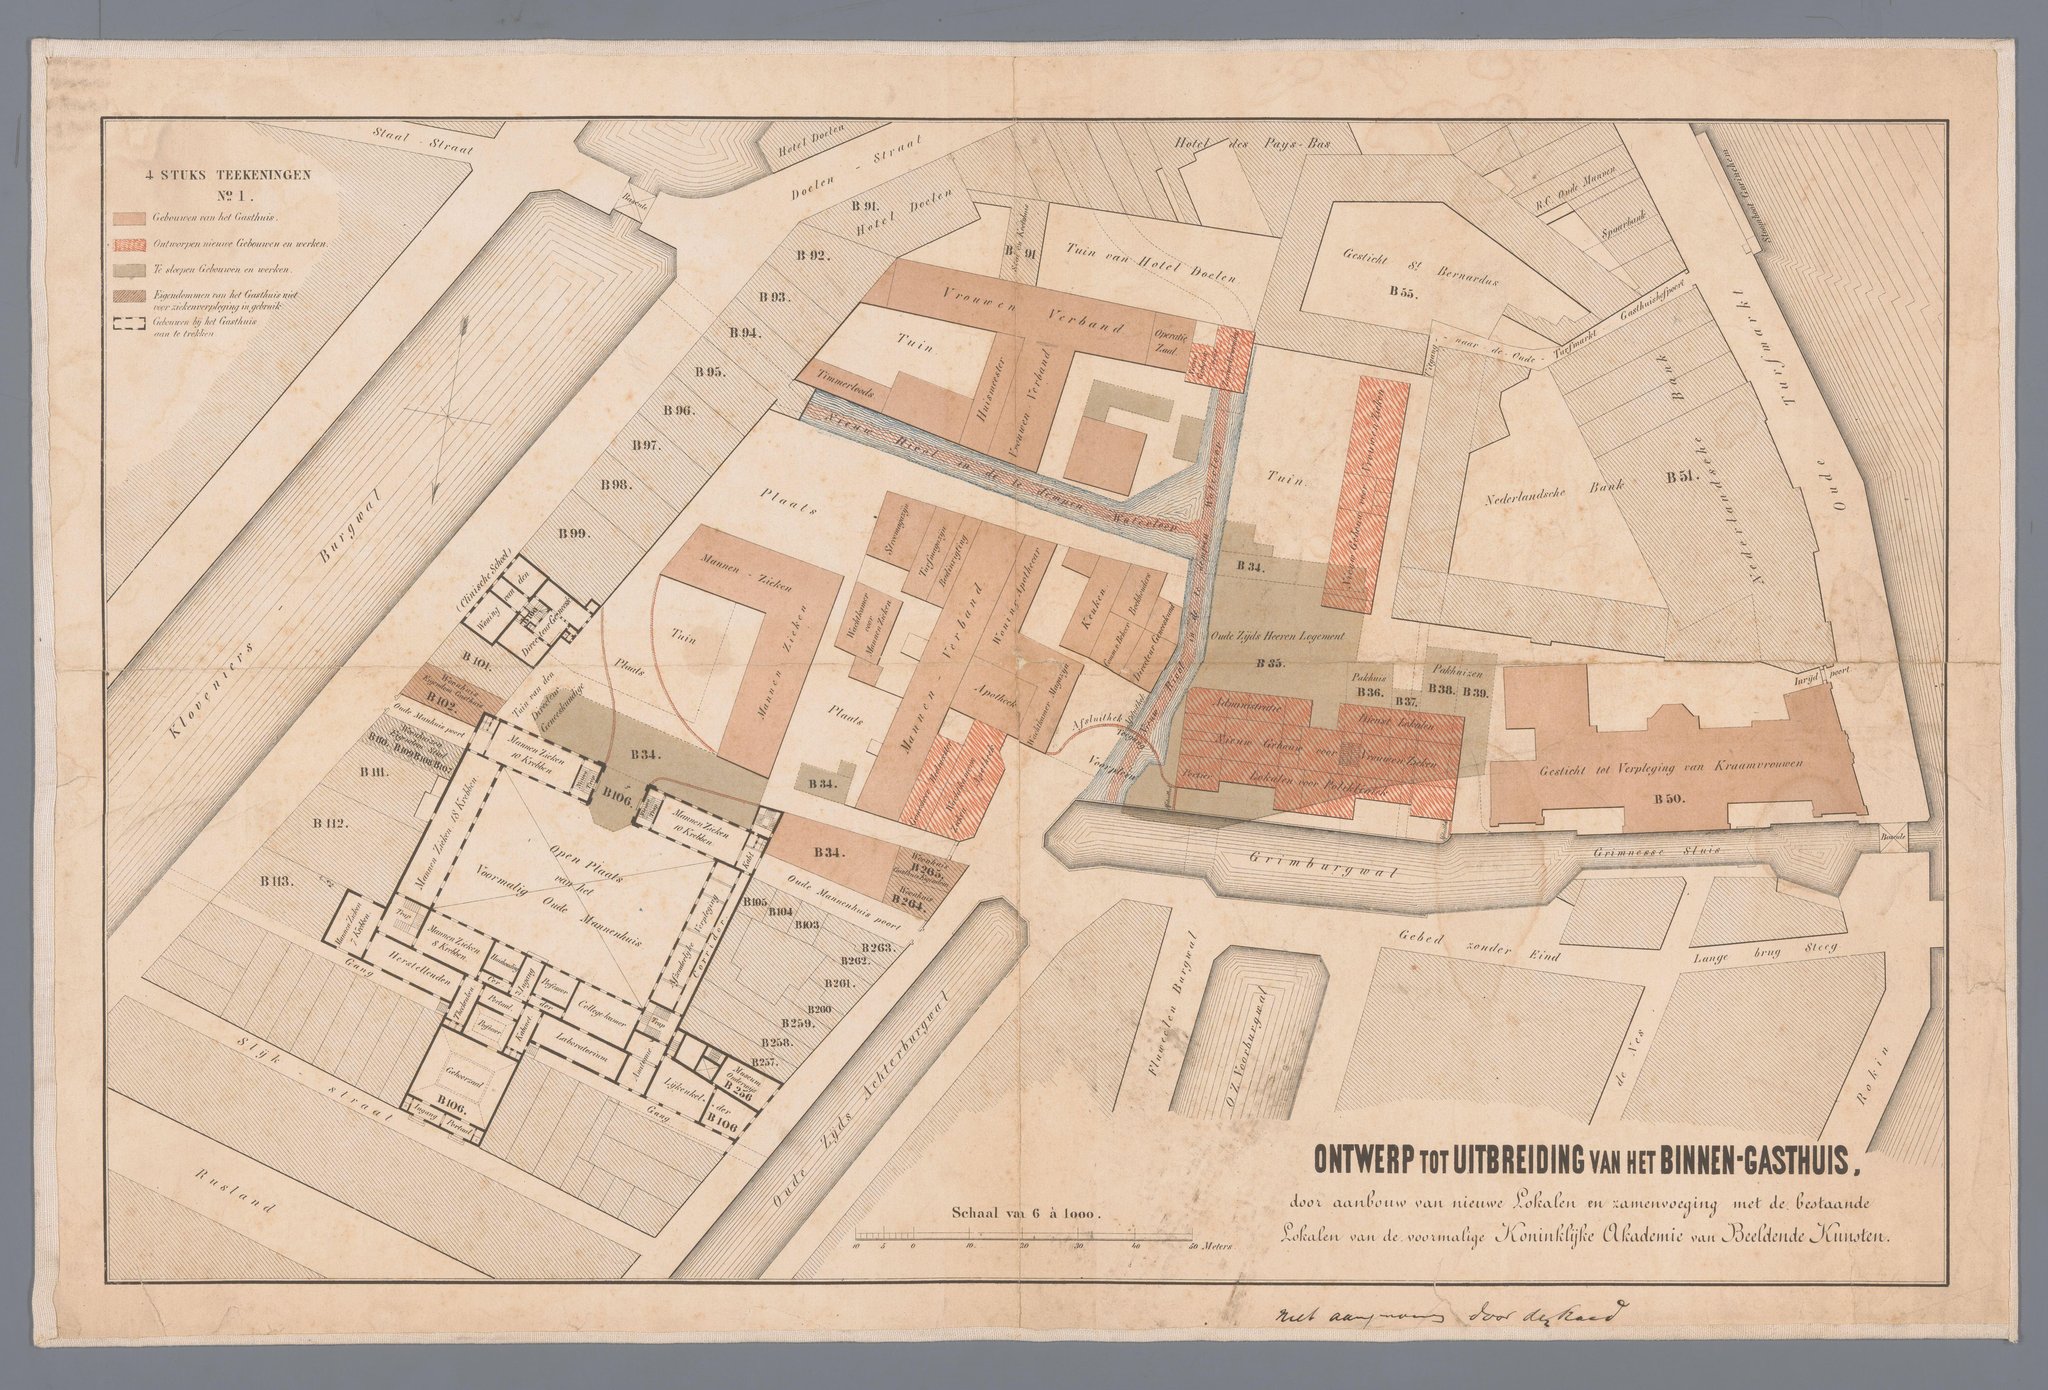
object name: print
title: Plattegrond van het ontwerp van de uitbreiding van het Binnengasthuis in Amsterdam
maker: Anonymous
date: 1870-1920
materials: linen, paper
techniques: lithograph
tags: hospital, edifice, e.g.: public building, department store